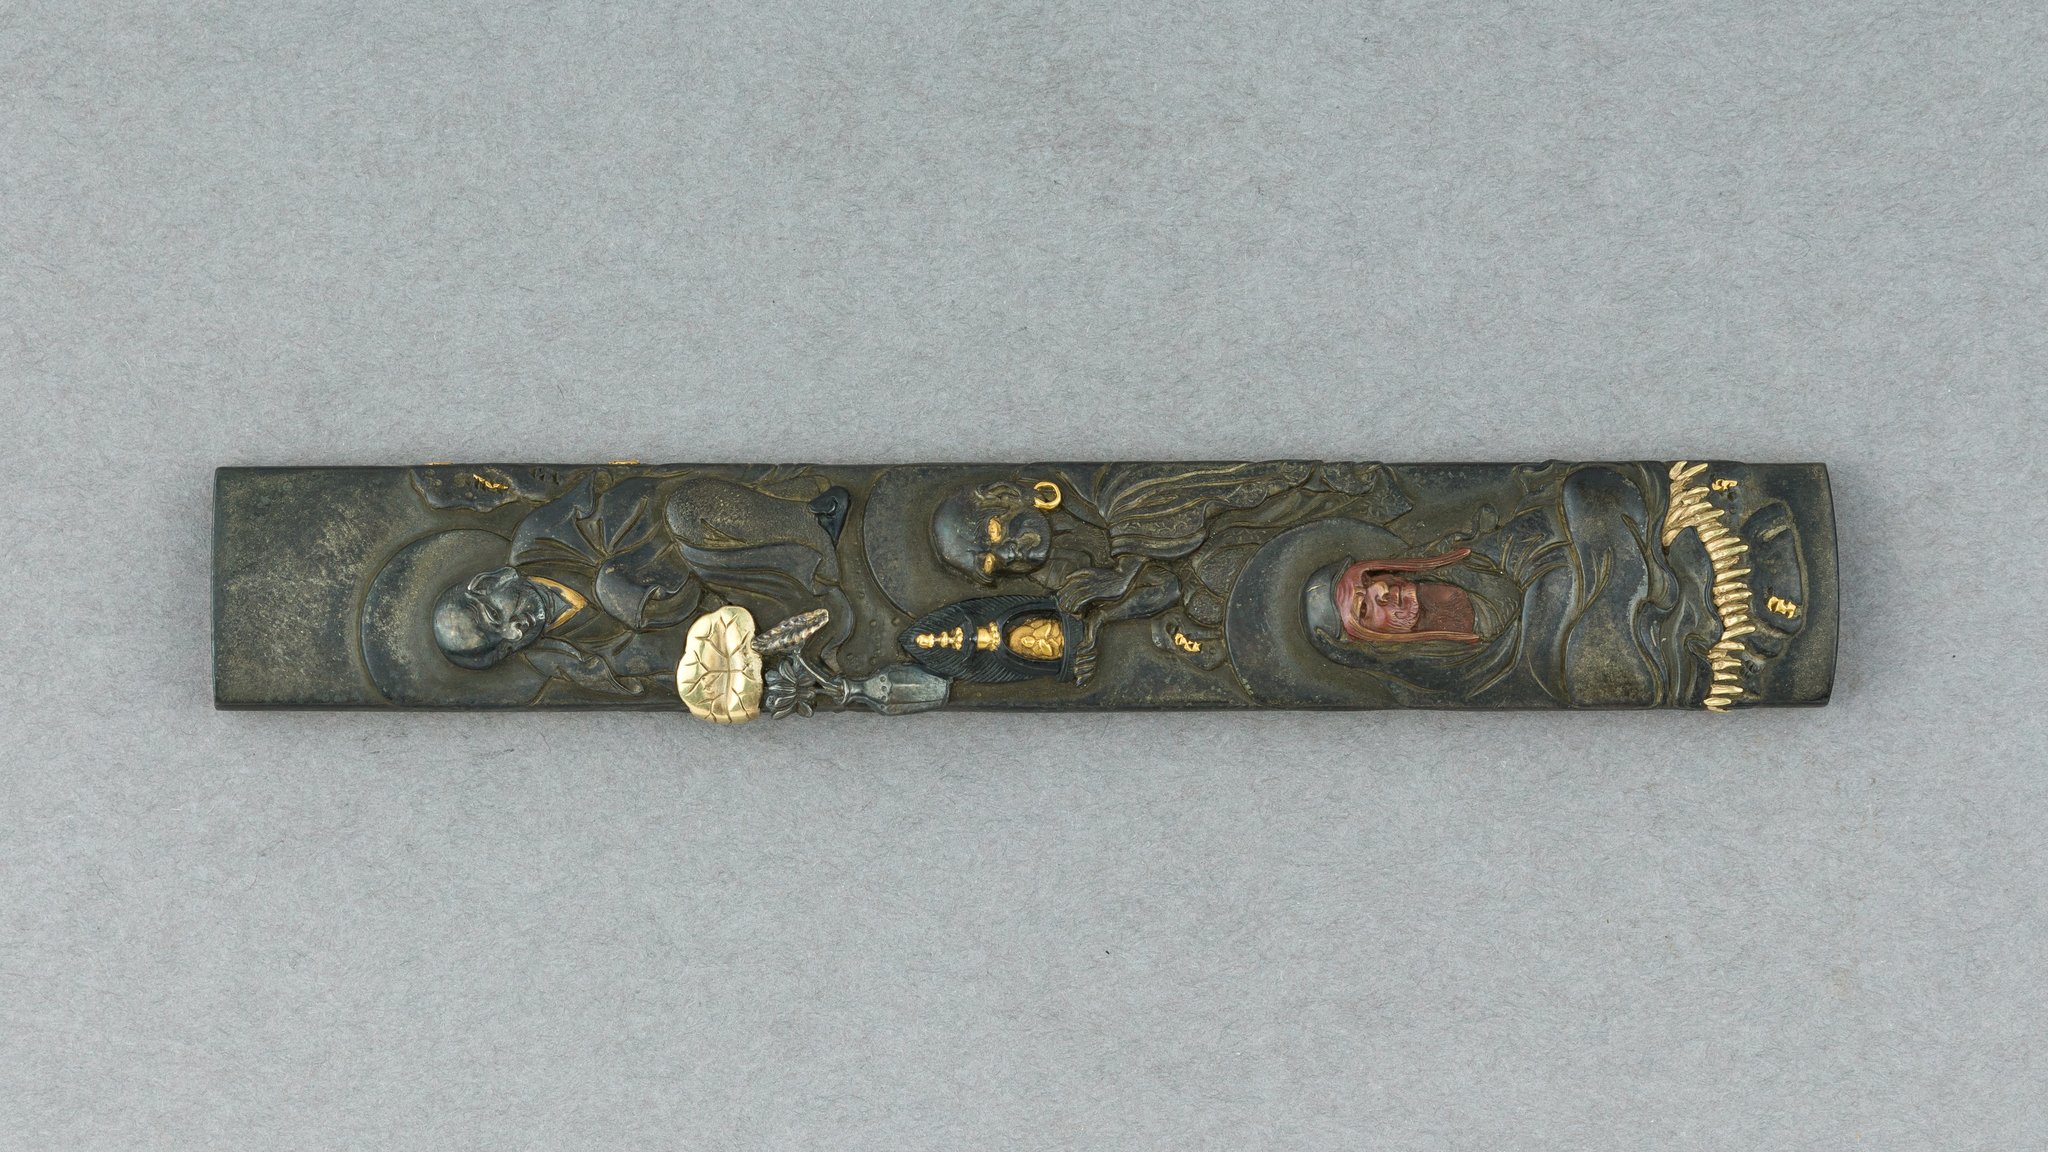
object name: knife handle kozuka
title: Knife Handle (Kozuka)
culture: japanese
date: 1615-1868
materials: copper, gold alloy, silver alloy, gold, silver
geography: japan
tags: men